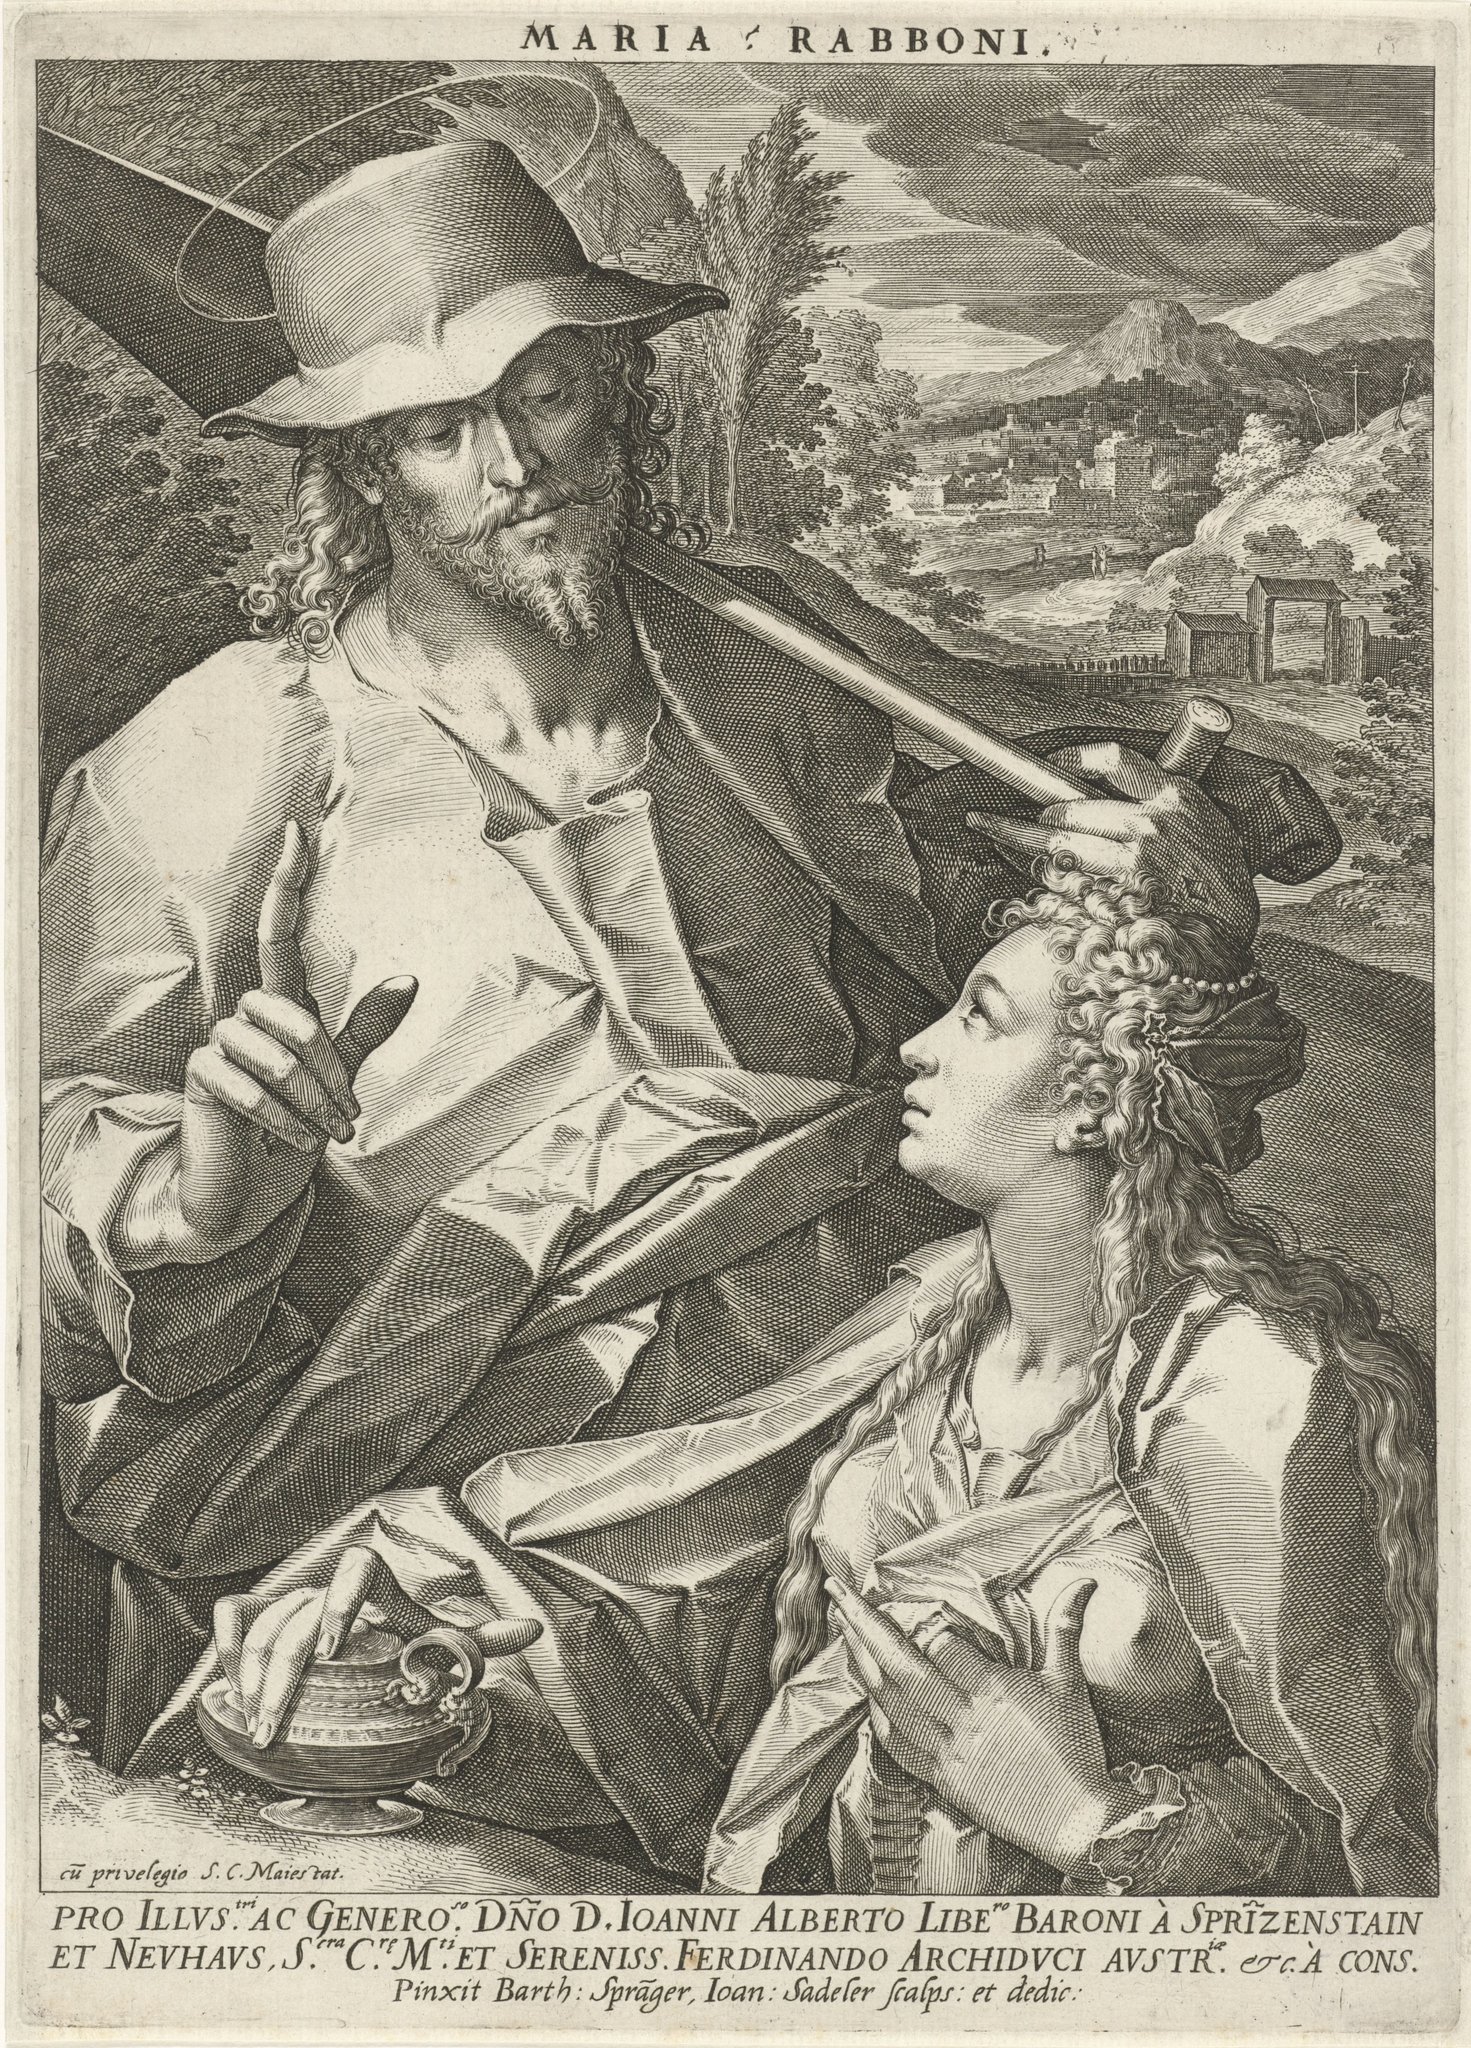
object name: print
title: Maria Rabboni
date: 1588-1595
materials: paper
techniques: engraving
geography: munich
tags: mary magdalene kneeling before christ, who is usually represented as a gardener with a hoe and/or a spade; 'noli me tangere'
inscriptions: collector's mark: Lugt 240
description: De verrezen Christus (links) verschijnt aan Maria Magdalena (rechts) in de gedaante van een tuinman. Maria Magdalena heeft een zalfpot in de hand.